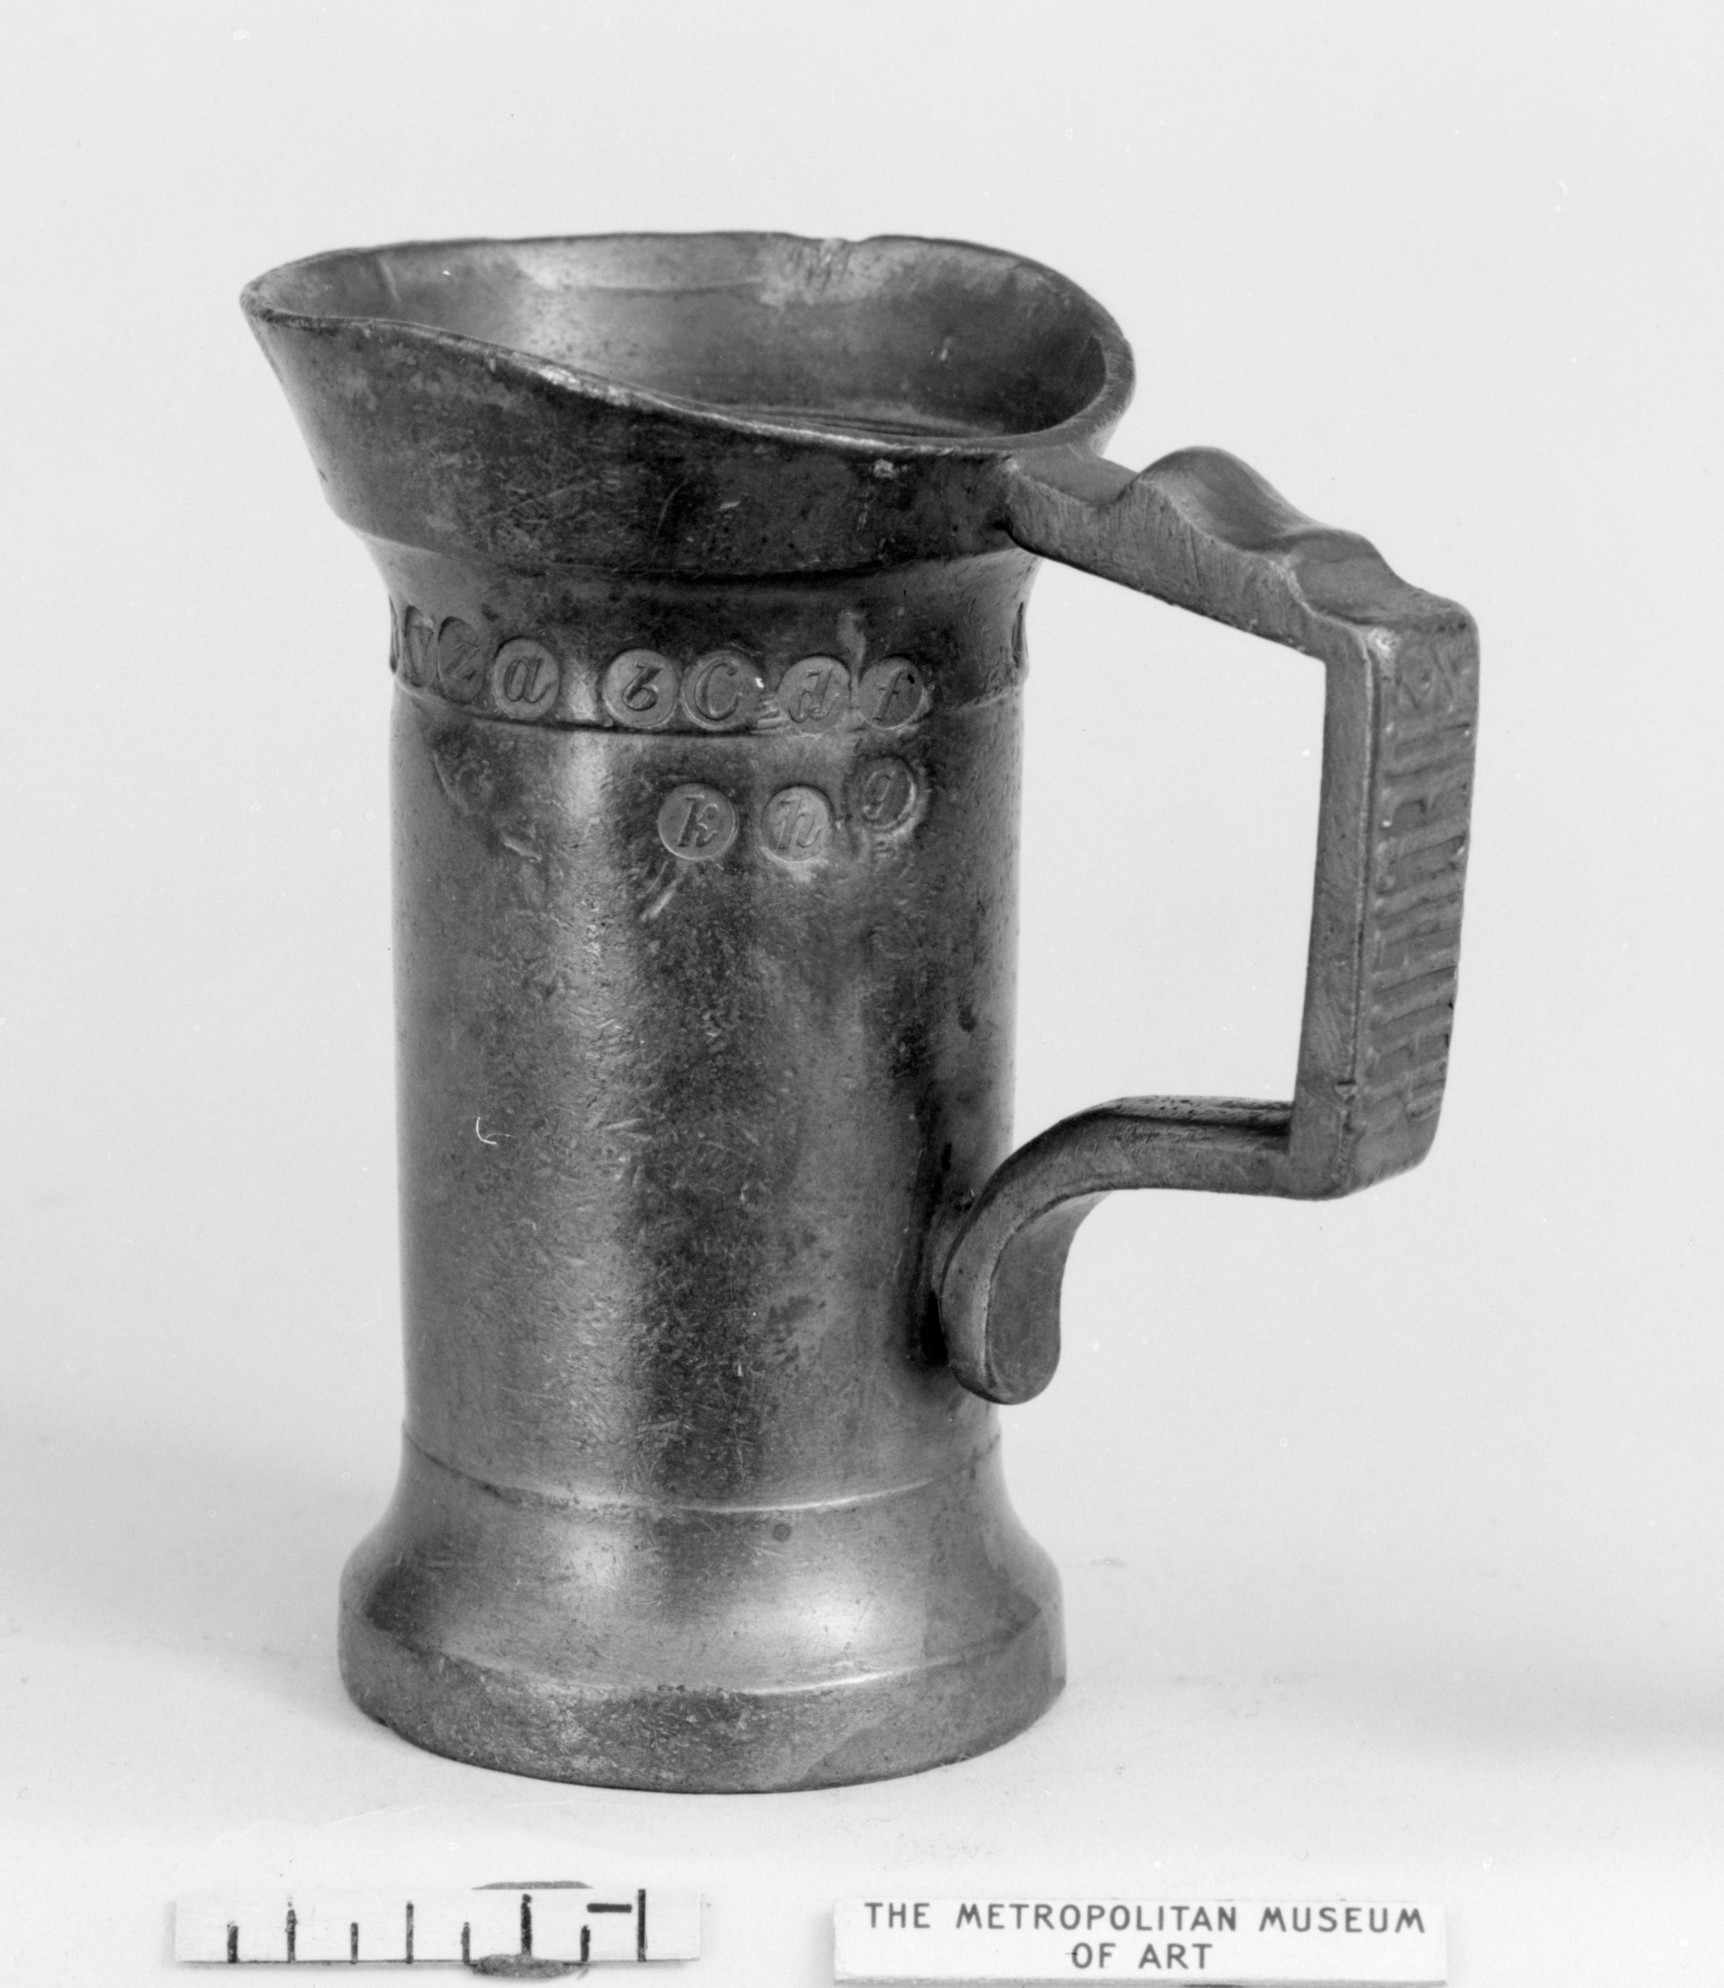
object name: measure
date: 1767-1833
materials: pewter